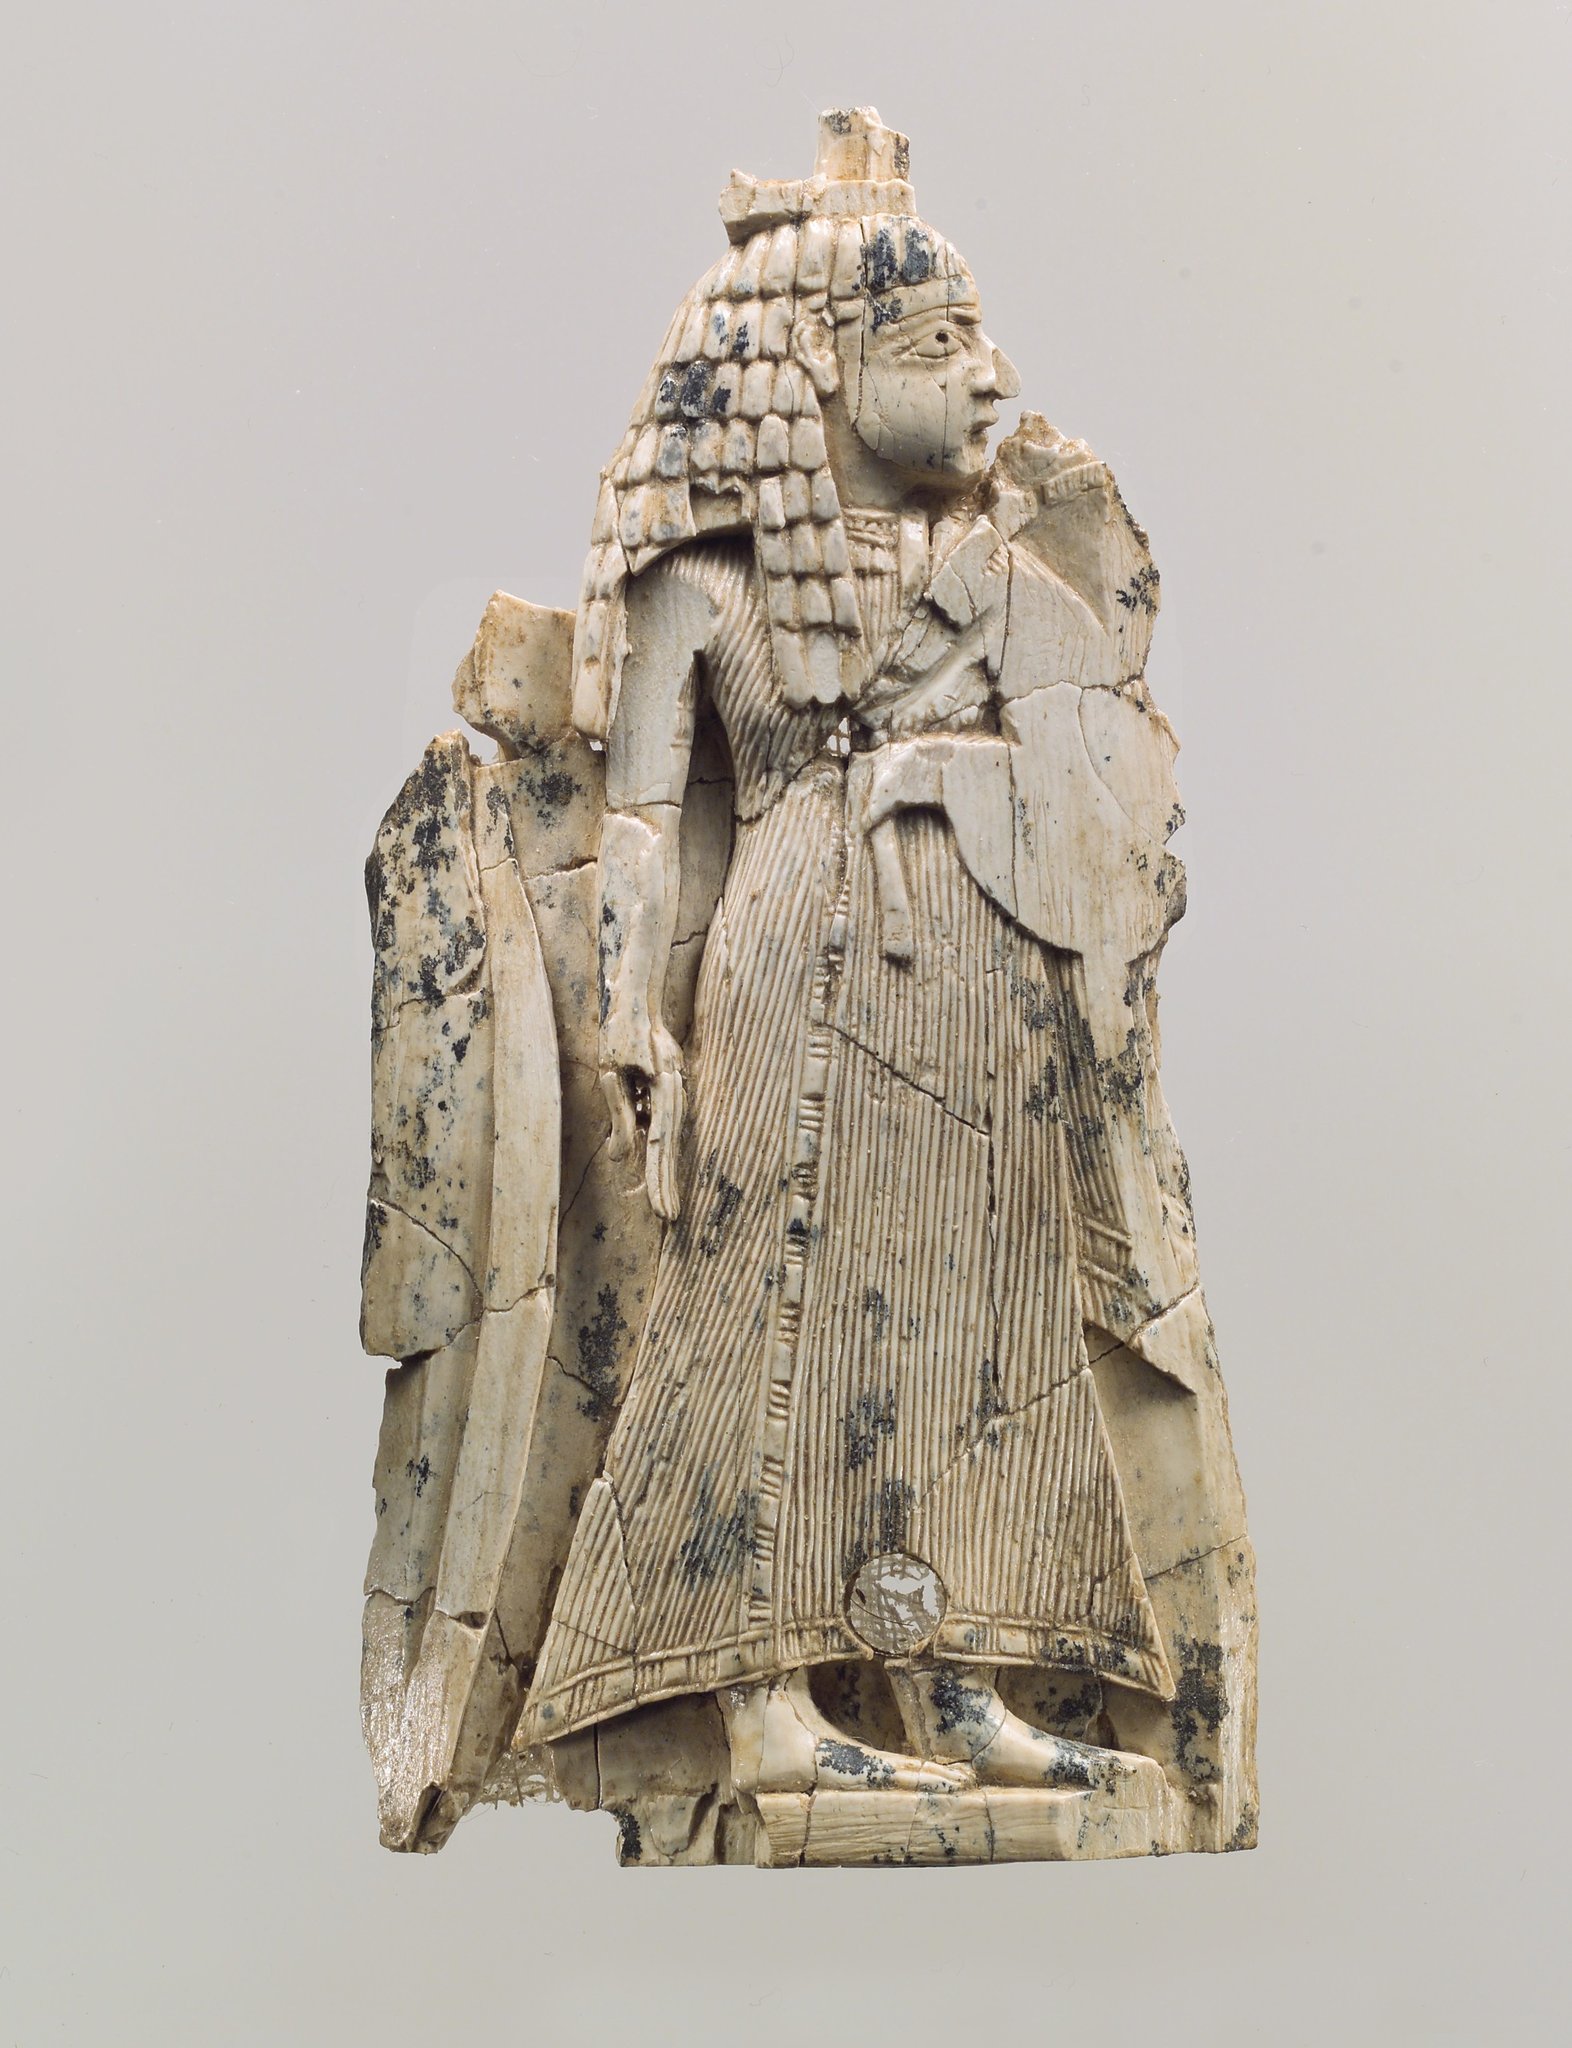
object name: relief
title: Furniture plaque carved in relief with a female figure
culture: assyrian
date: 900-701 BCE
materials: ivory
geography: mesopotamia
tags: women